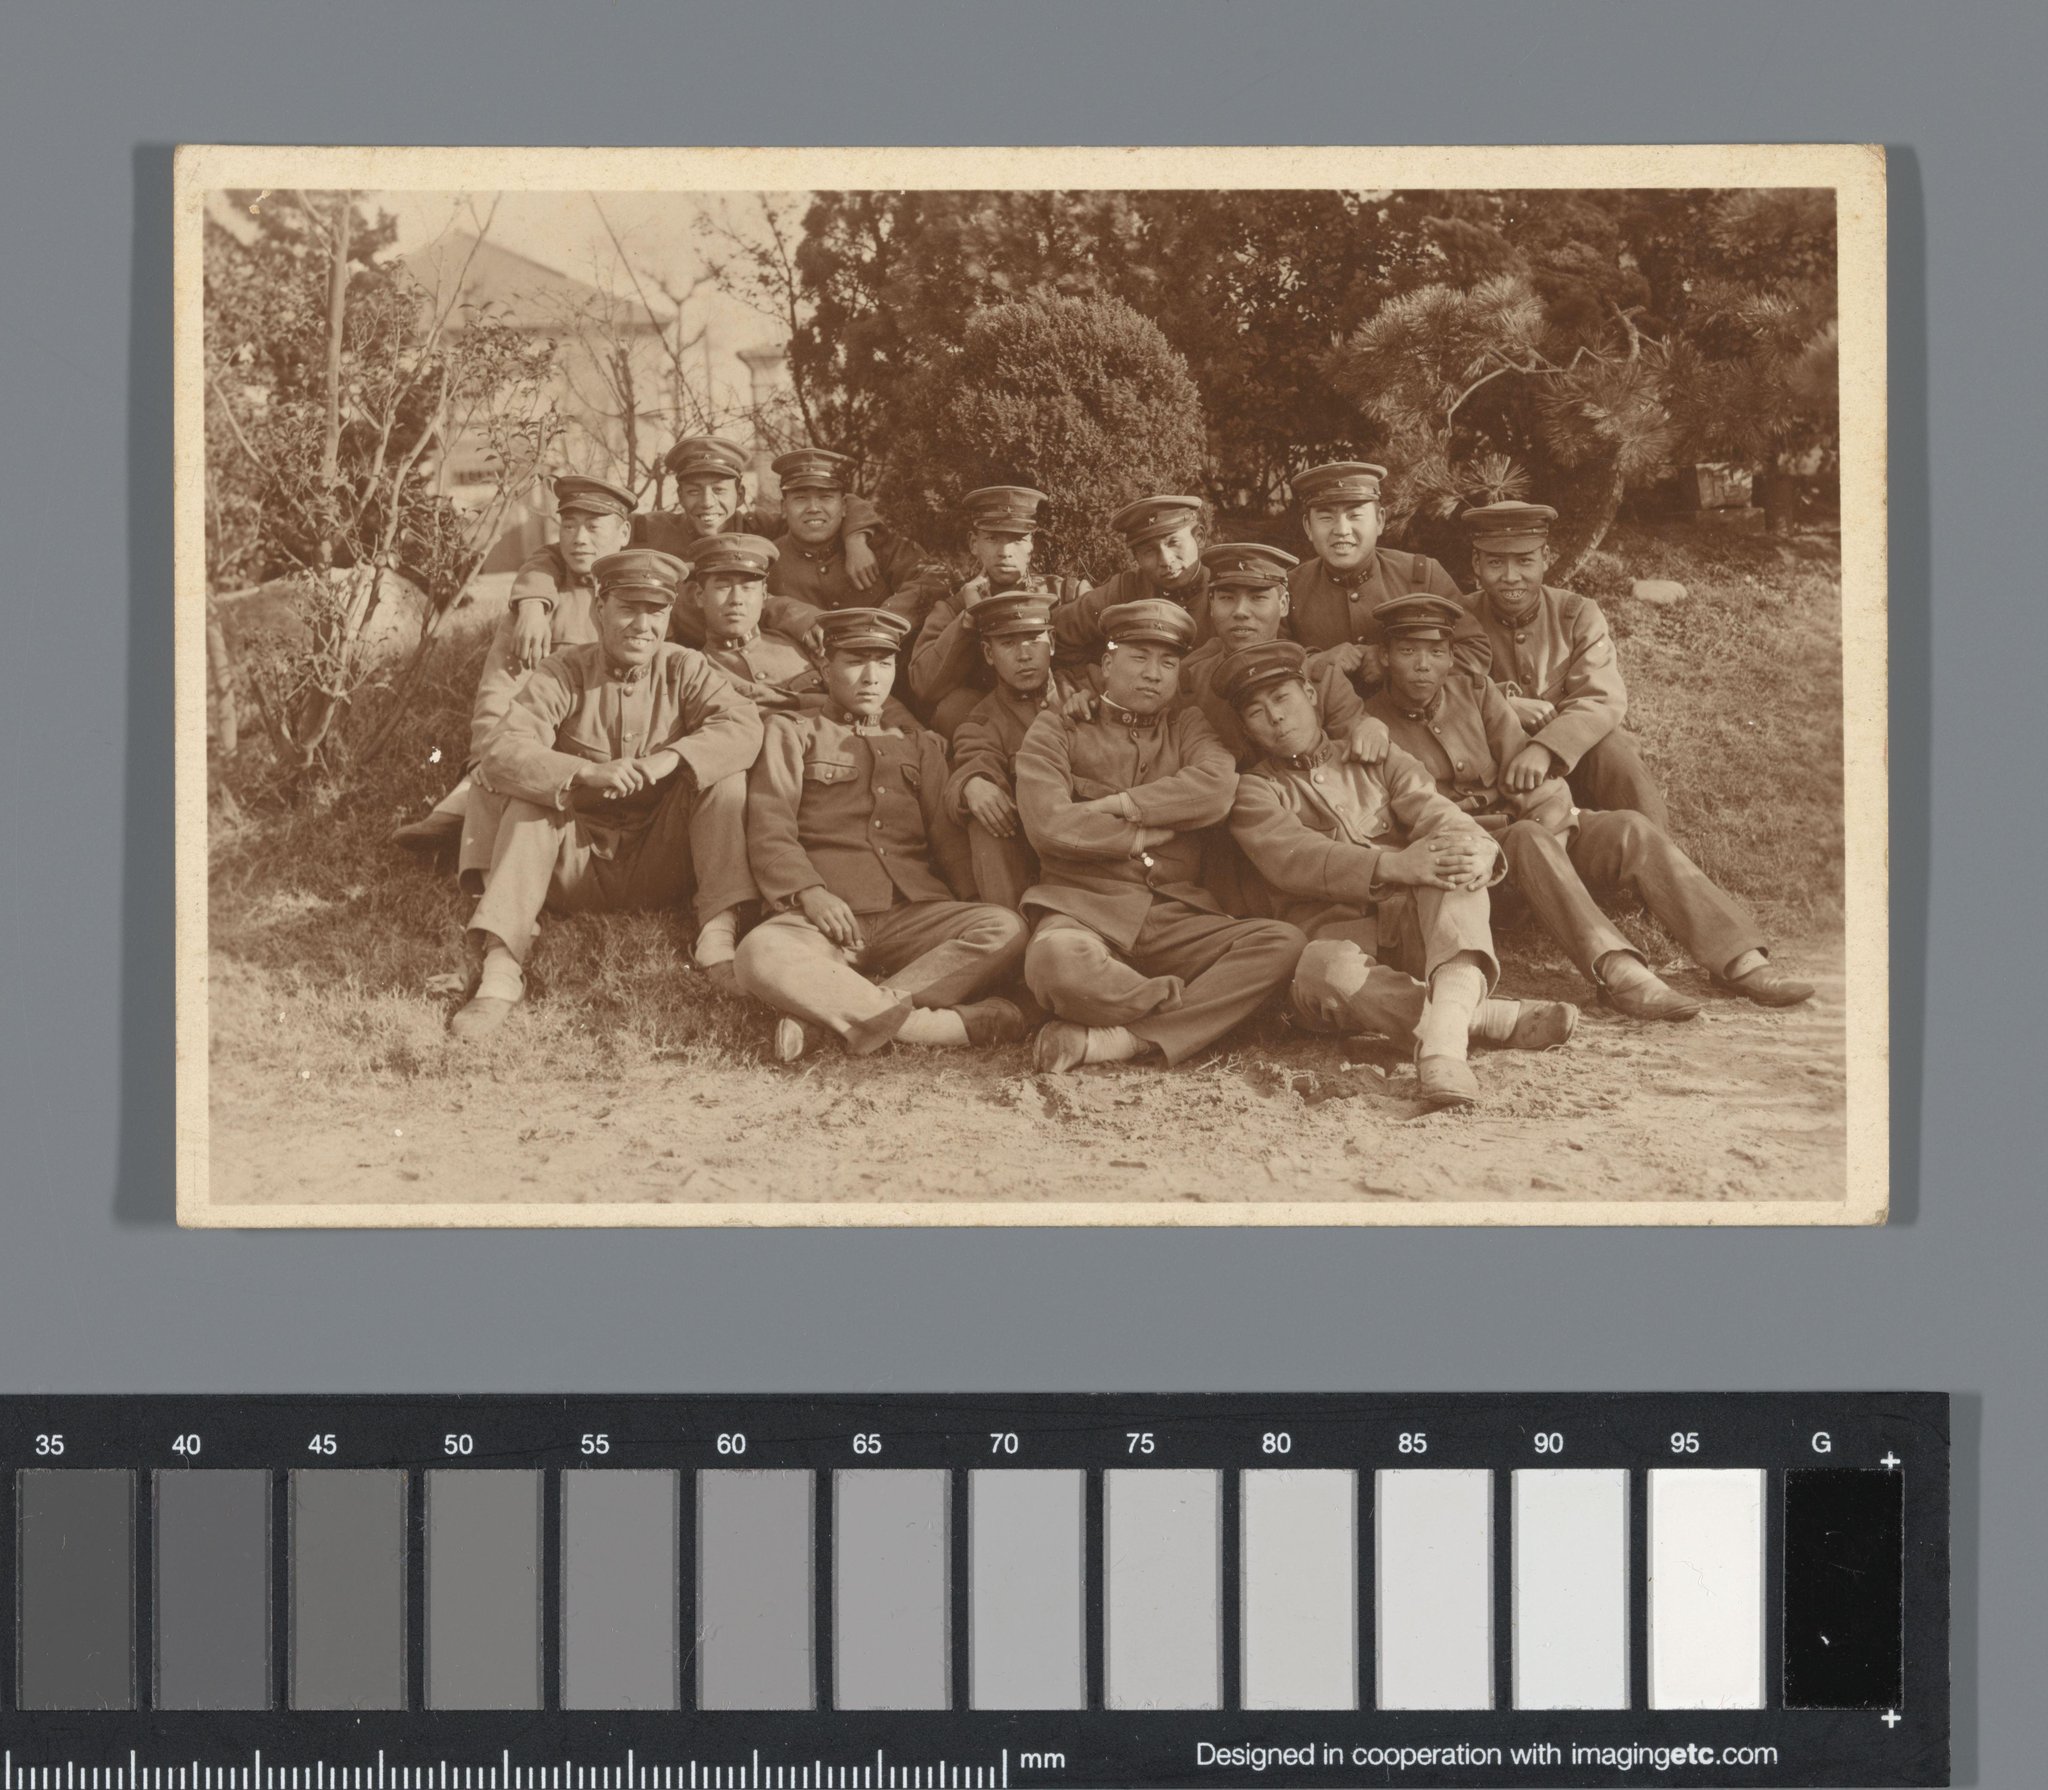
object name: photograph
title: Groepsportret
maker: Anonymous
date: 1930-1940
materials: photographic support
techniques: gelatin silver print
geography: japan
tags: the company, the unit, the troop ~ military service, military training, japan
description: Groepsportret van een groep Japanse militairen. Losse foto in het leporello fotoalbum met foto’s van de diensttijd van Japanse militairen.